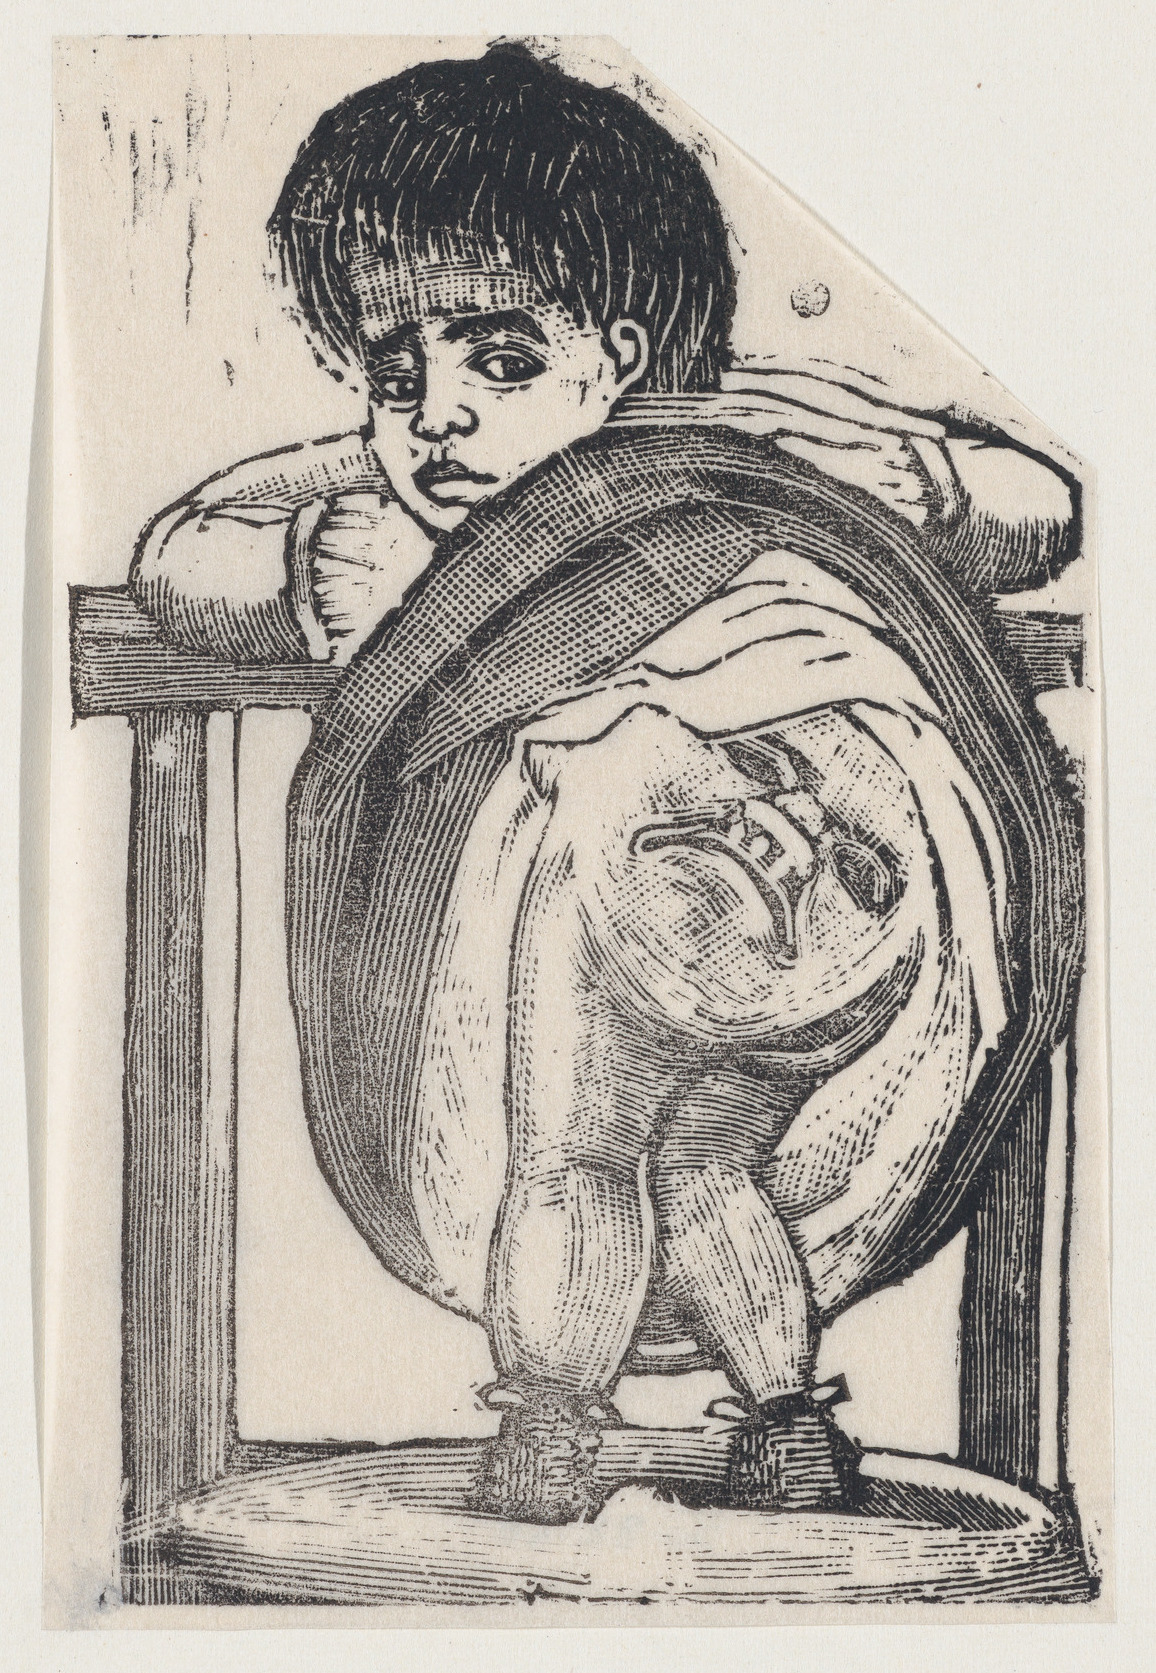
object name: print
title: A girl with two faces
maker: josé guadalupe posada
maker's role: artist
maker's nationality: mexican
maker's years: 1852-1913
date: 1892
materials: metal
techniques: engraving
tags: faces,girls